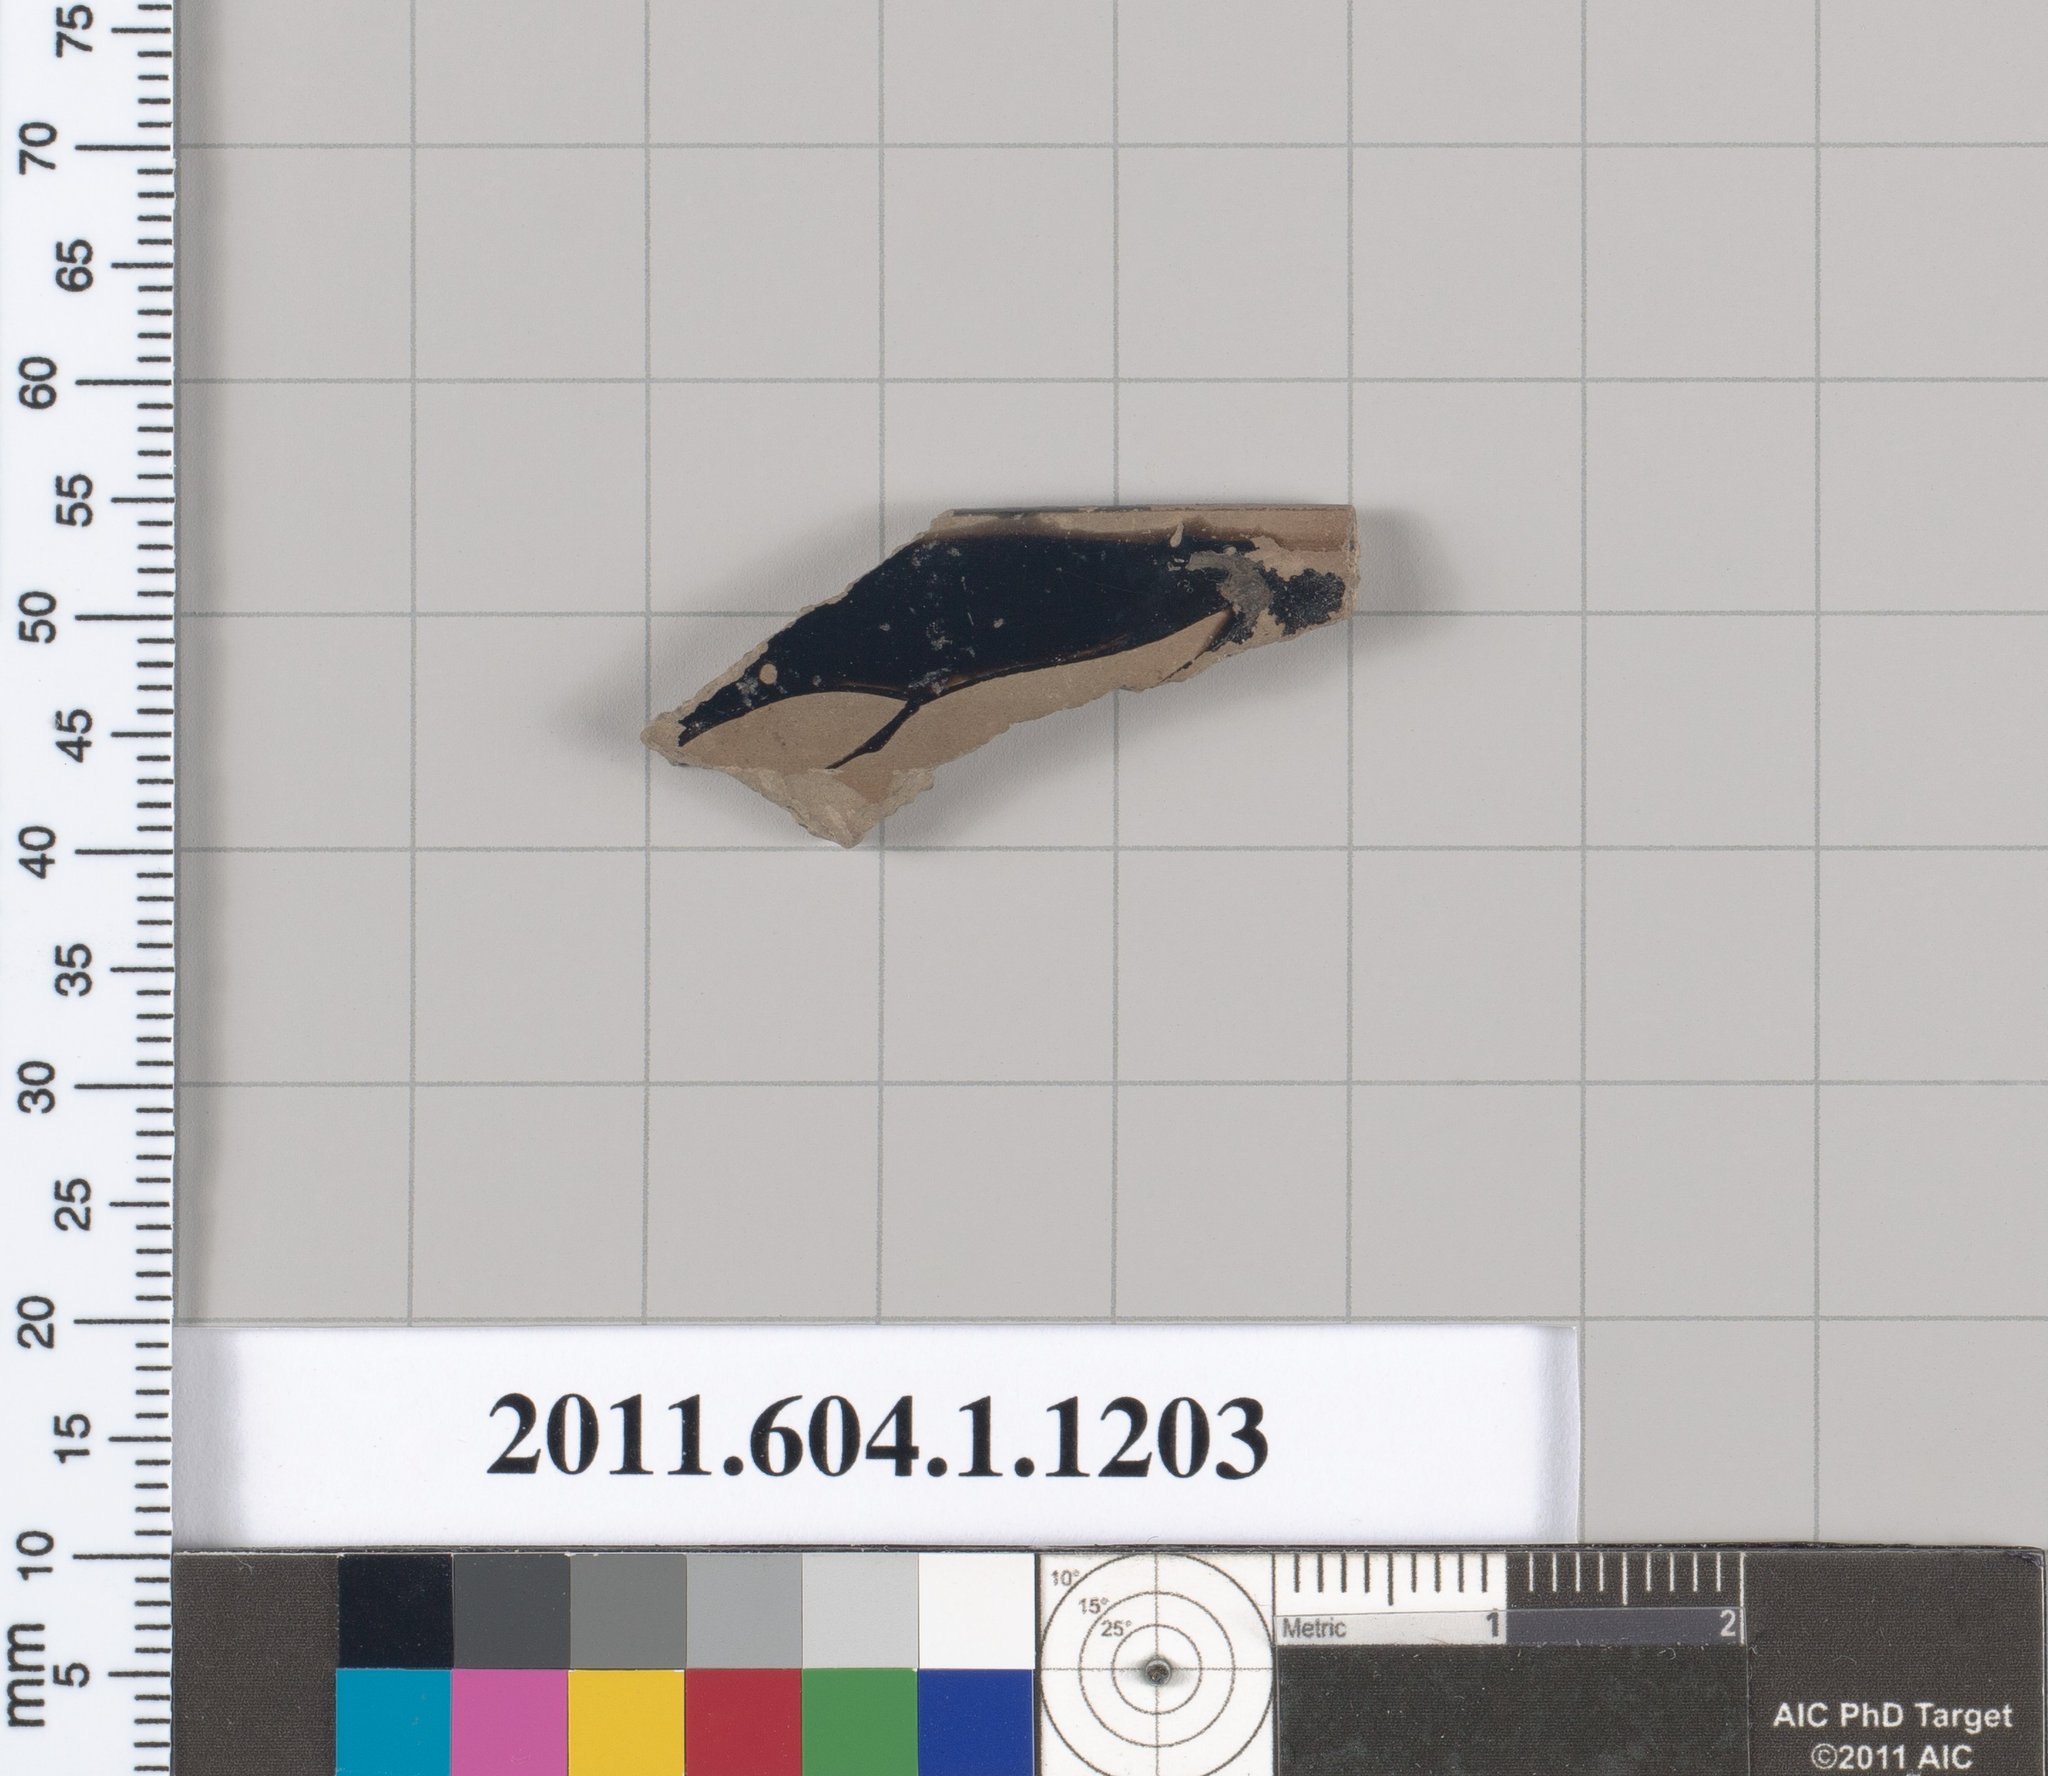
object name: kylix fragment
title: Terracotta rim fragment of a kylix (drinking cup)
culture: greek, attic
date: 490-480 BCE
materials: terracotta